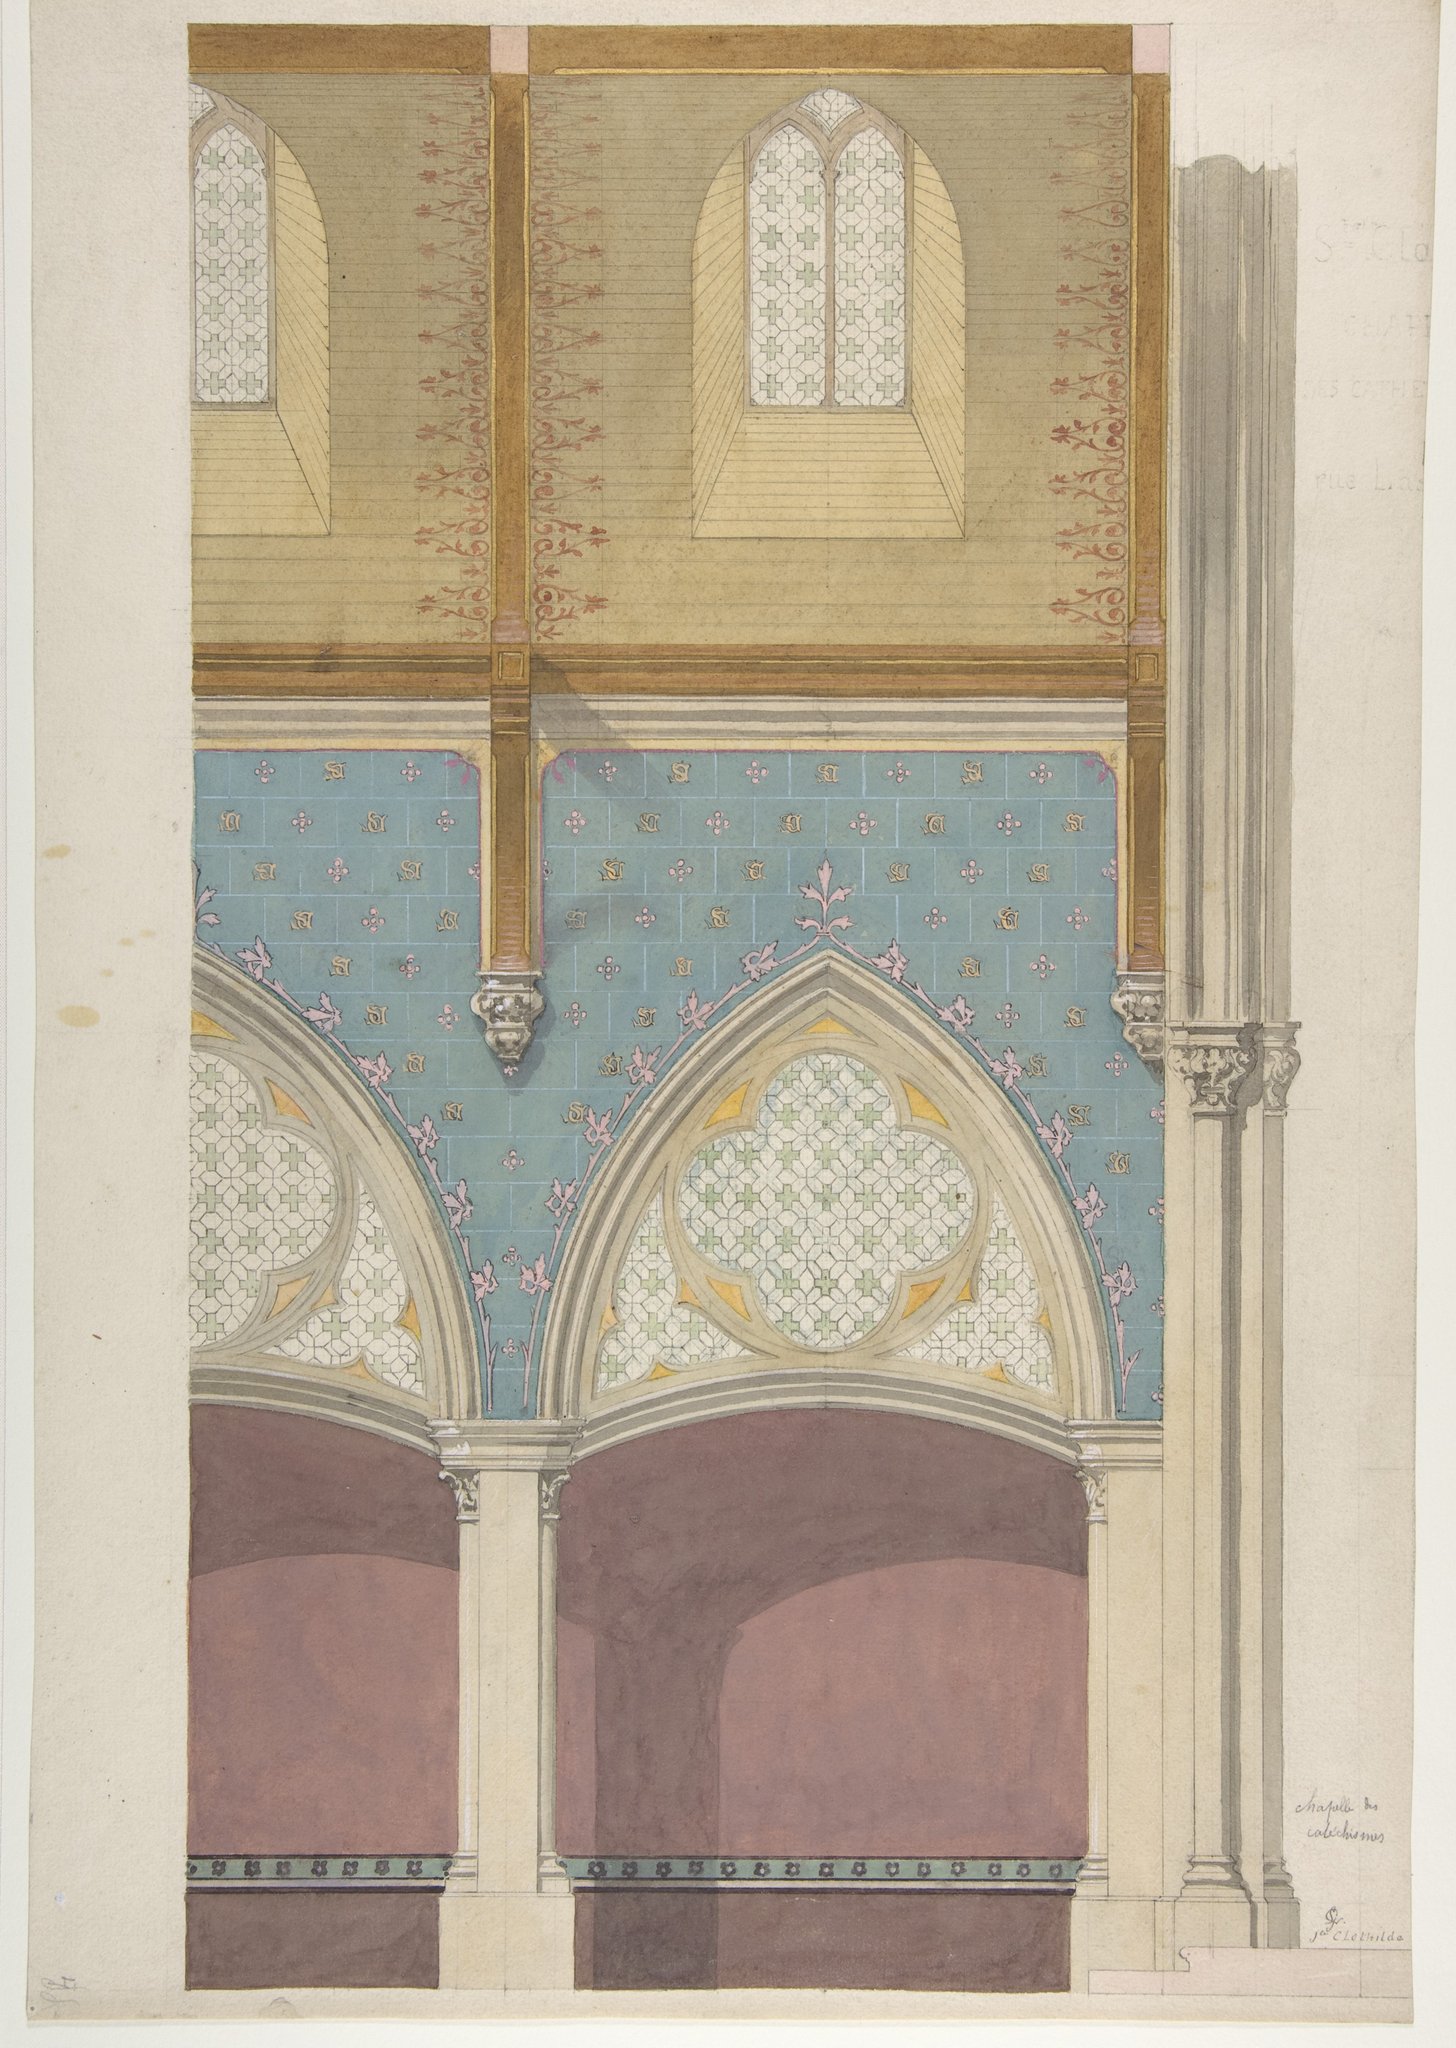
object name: drawing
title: Elevation of Nave, Chapelle des Catéchismes, Ste Clothilde, Paris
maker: jules-edmond-charles lachaise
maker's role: artist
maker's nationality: french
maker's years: 1897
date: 1851-1900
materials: gilt, gouache, graphite, ink, watercolor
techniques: brush, pen, wash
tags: architecture,churches